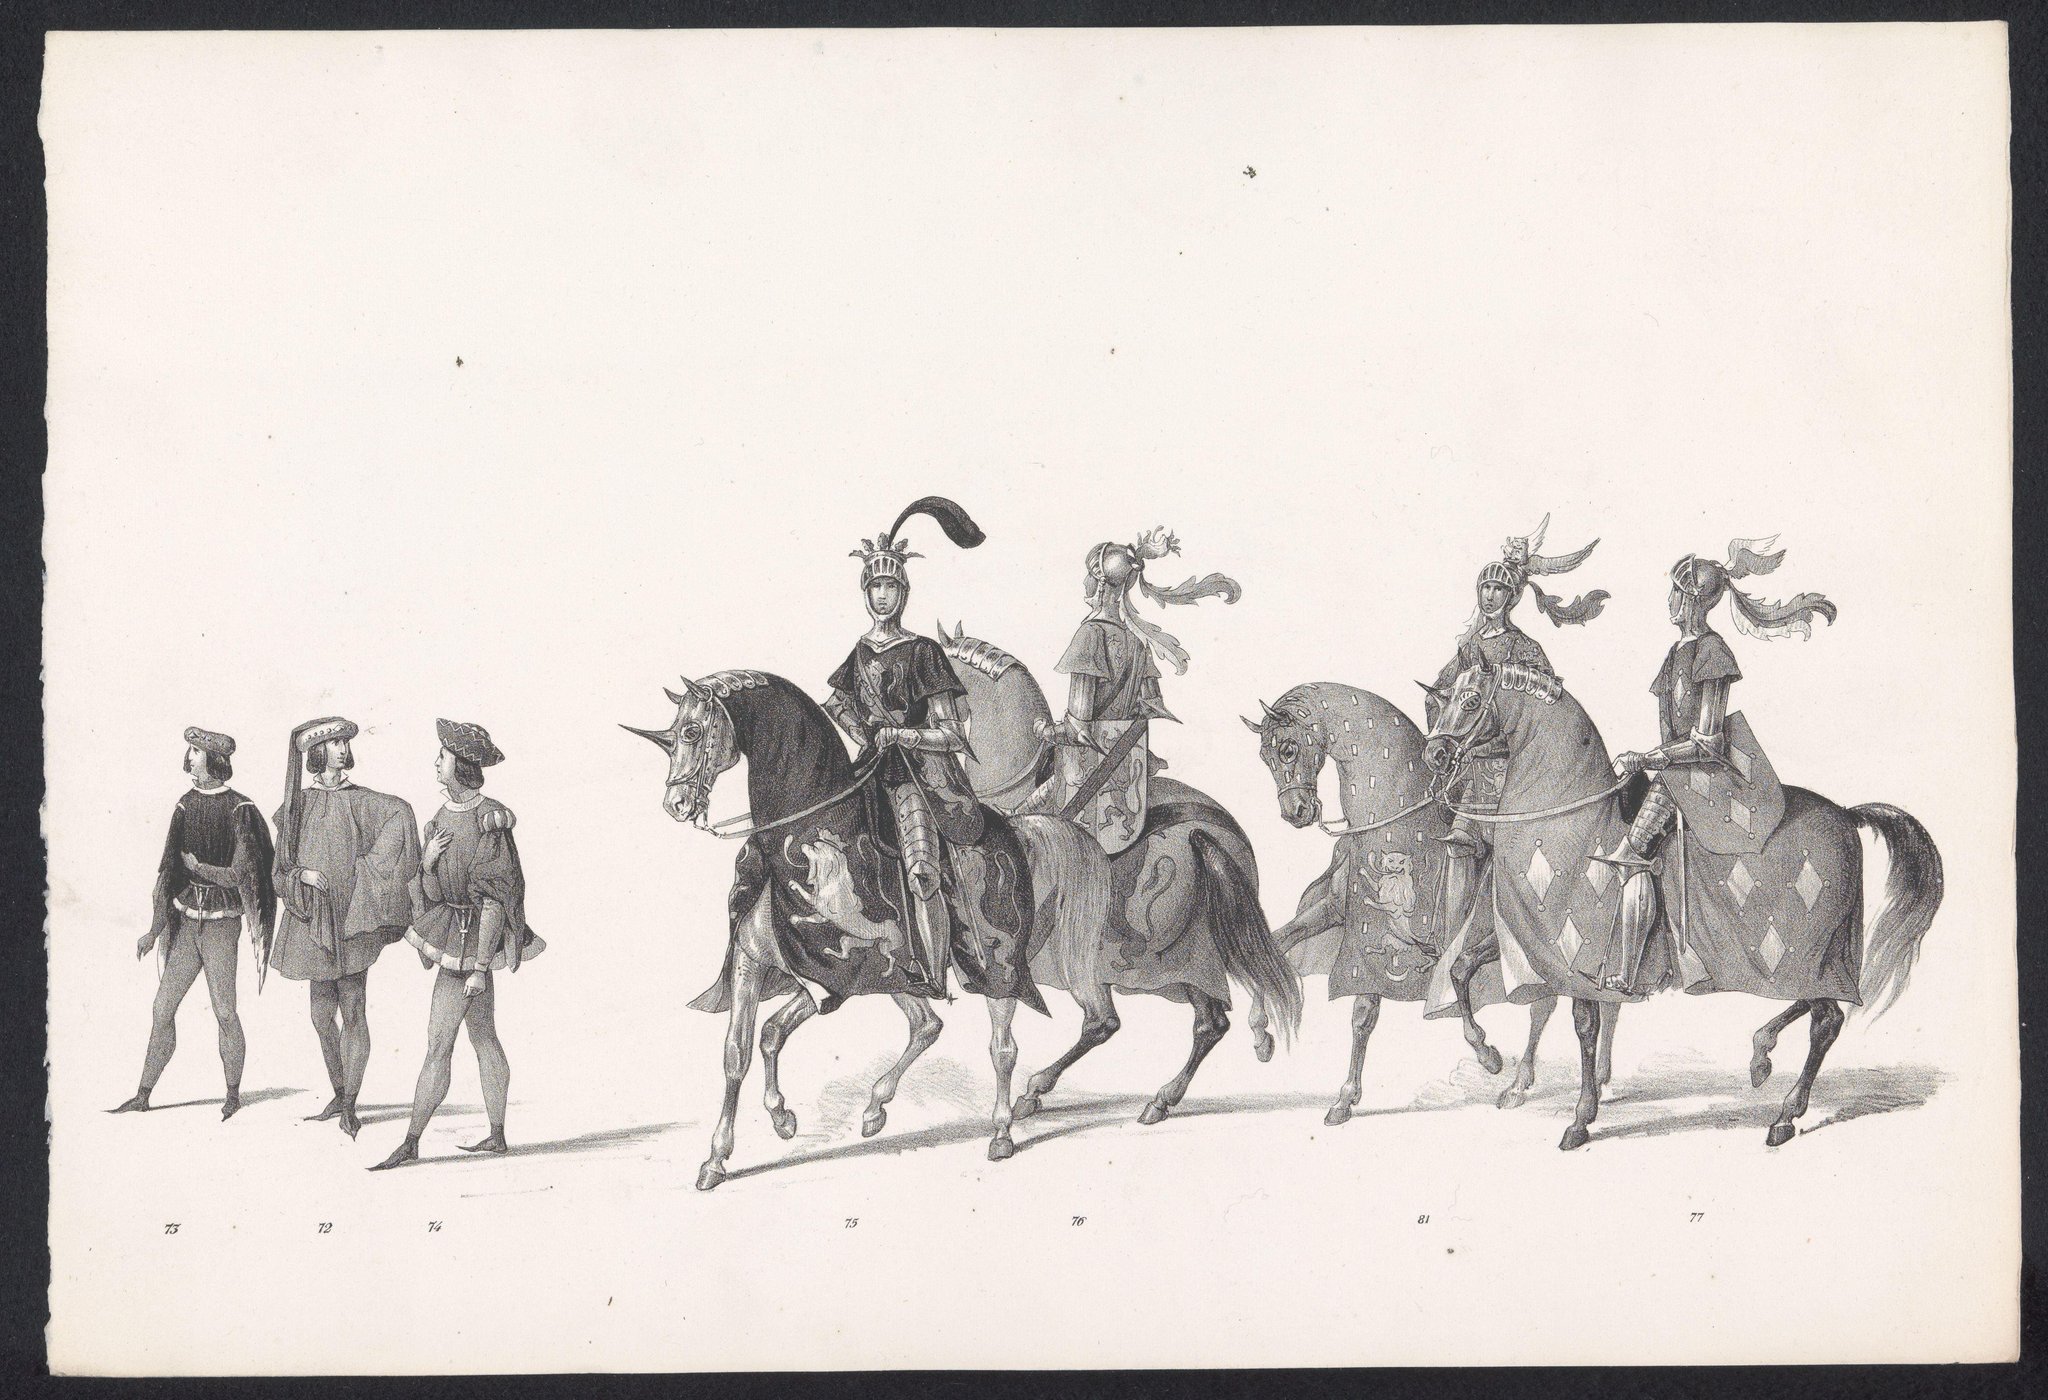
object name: print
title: De intogt van Hertog Jan van Beijeren binnen Leijden, Op den 18den Augustus 1420, in maskerade voorgesteld door H.H. Studenten der Leydsche Hoogeschool, Op den 8sten Februarij 1840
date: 1840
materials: paper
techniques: lithograph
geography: leiden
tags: jan van beieren, students' pageant, costumes used in pageants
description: Historische gekostumeerde optocht van de studenten van de Hogeschool van Leiden op 8 februari 1840. De optocht verbeeldt de intocht van hertog Jan van Beieren te Leiden op 18 augustus 1420. Elfde plaat in een serie van negentien ongenummerde platen, met de groepen genummerd 72-77.